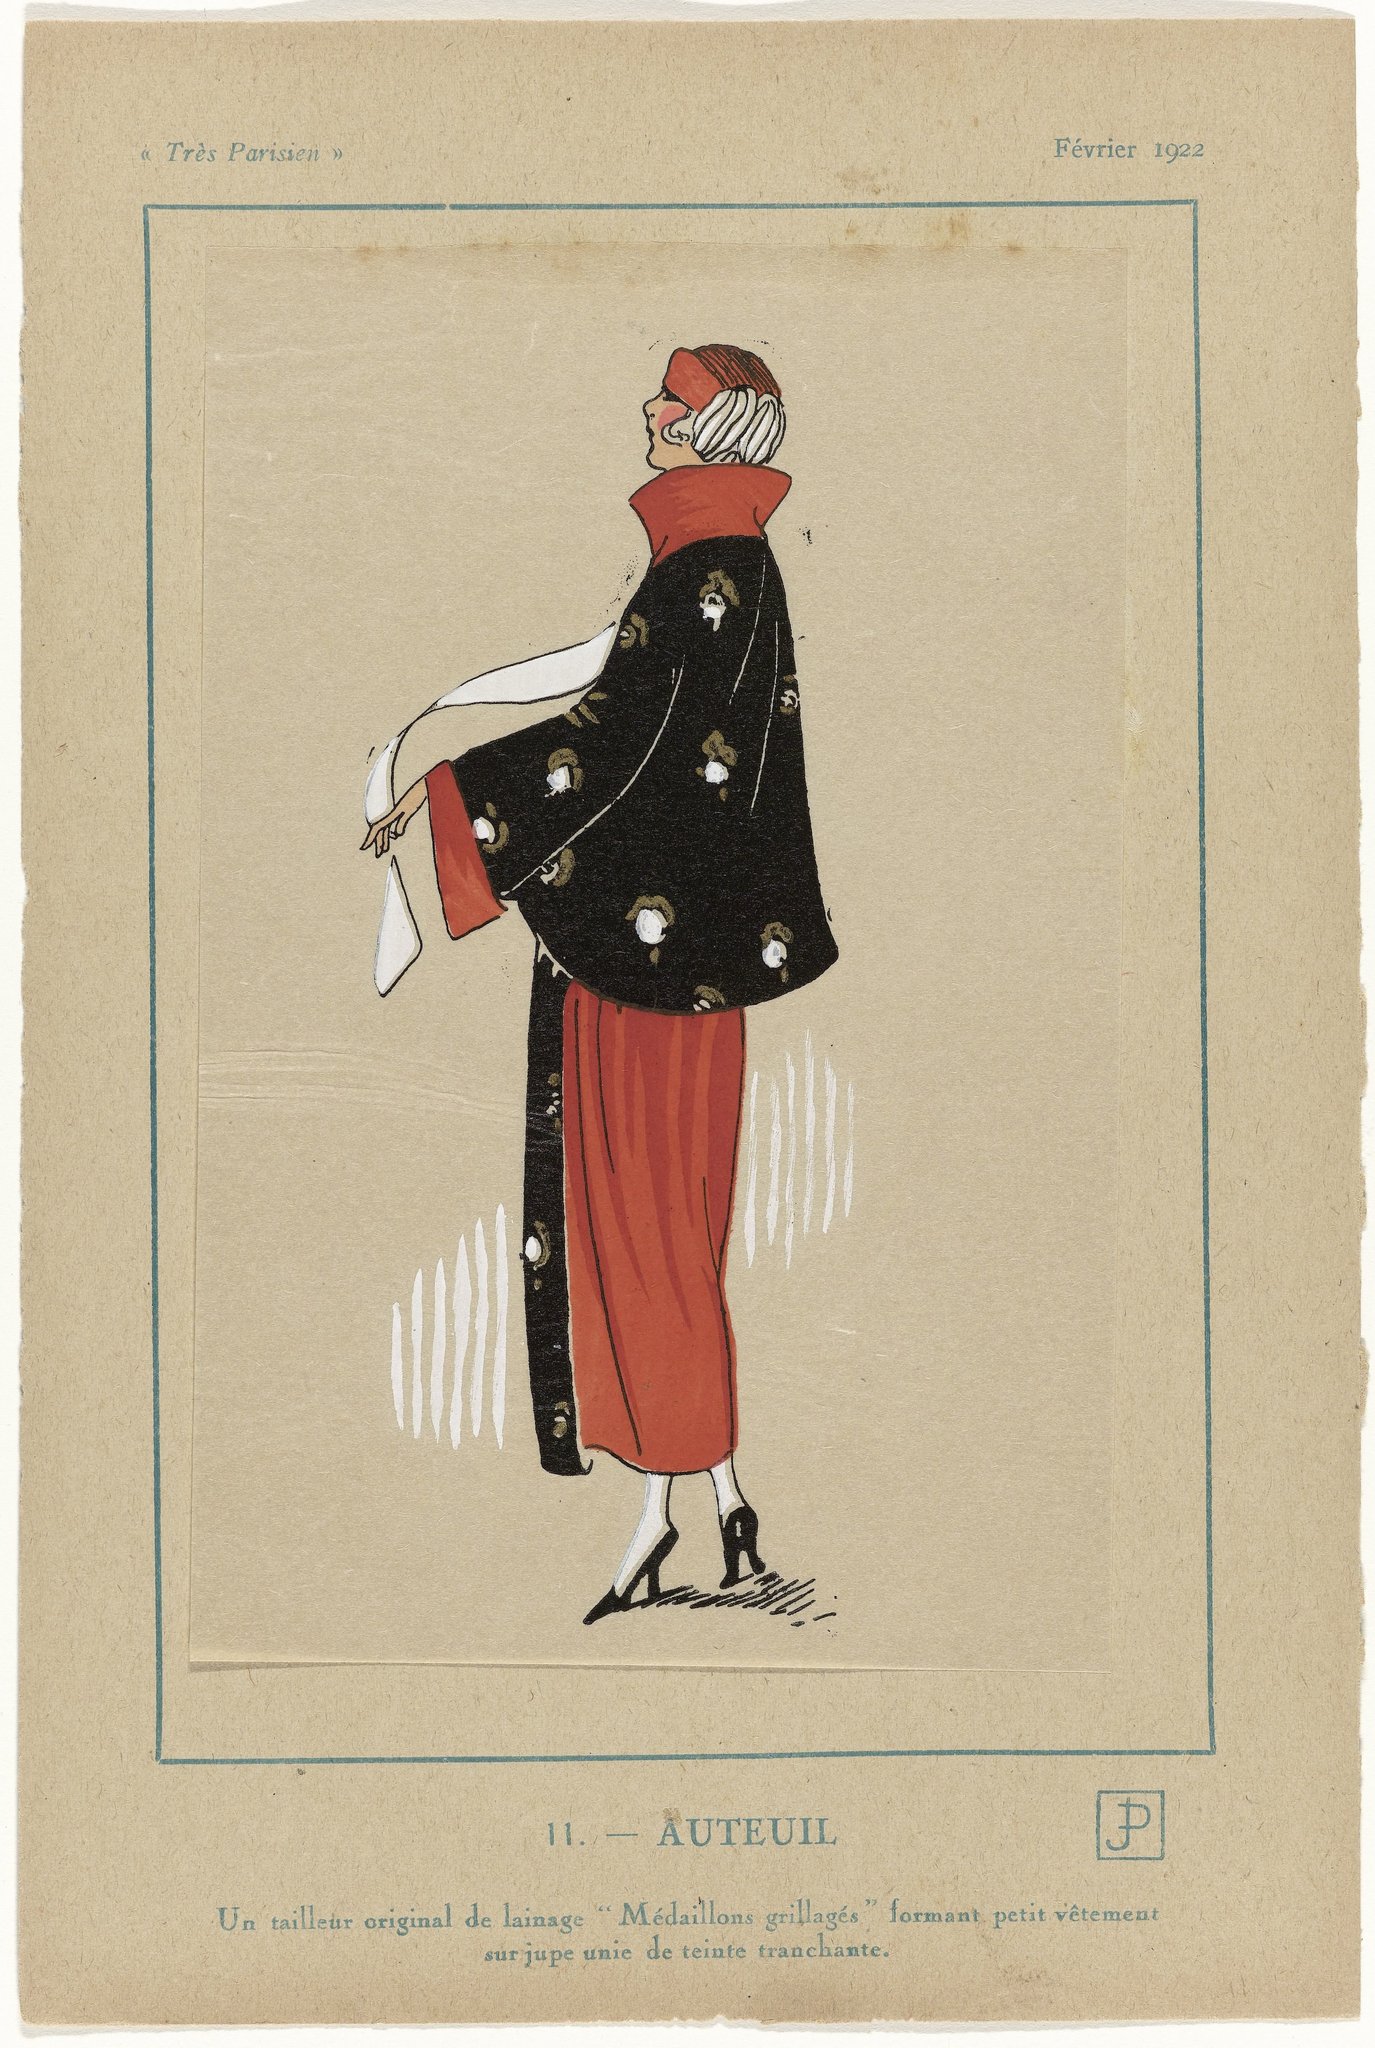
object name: fashion print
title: Très Parisien, février 1922 : 11.- AUTEUIL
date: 1922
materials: paper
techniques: brush, hand coloring, letterpress printing, lithography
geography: paris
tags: ensembles of pieces of clothing (suit) (+ women's clothes), fashion plates, head-gear: hat (+ women's clothes), skirt (+ women's clothes)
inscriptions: caption: ‘11. - AUTEUIL / Un tailleur original de lainage "Médaillons grillagés " formant petit vêtement sur jupe unie de teinte tranchante.’, title: ‘Très Parisien / Février 1922’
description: Zwarte tailleur met medaillons, op een rode wollen japon. Prent uit het modetijdschrift Très Parisien (1920-1936).